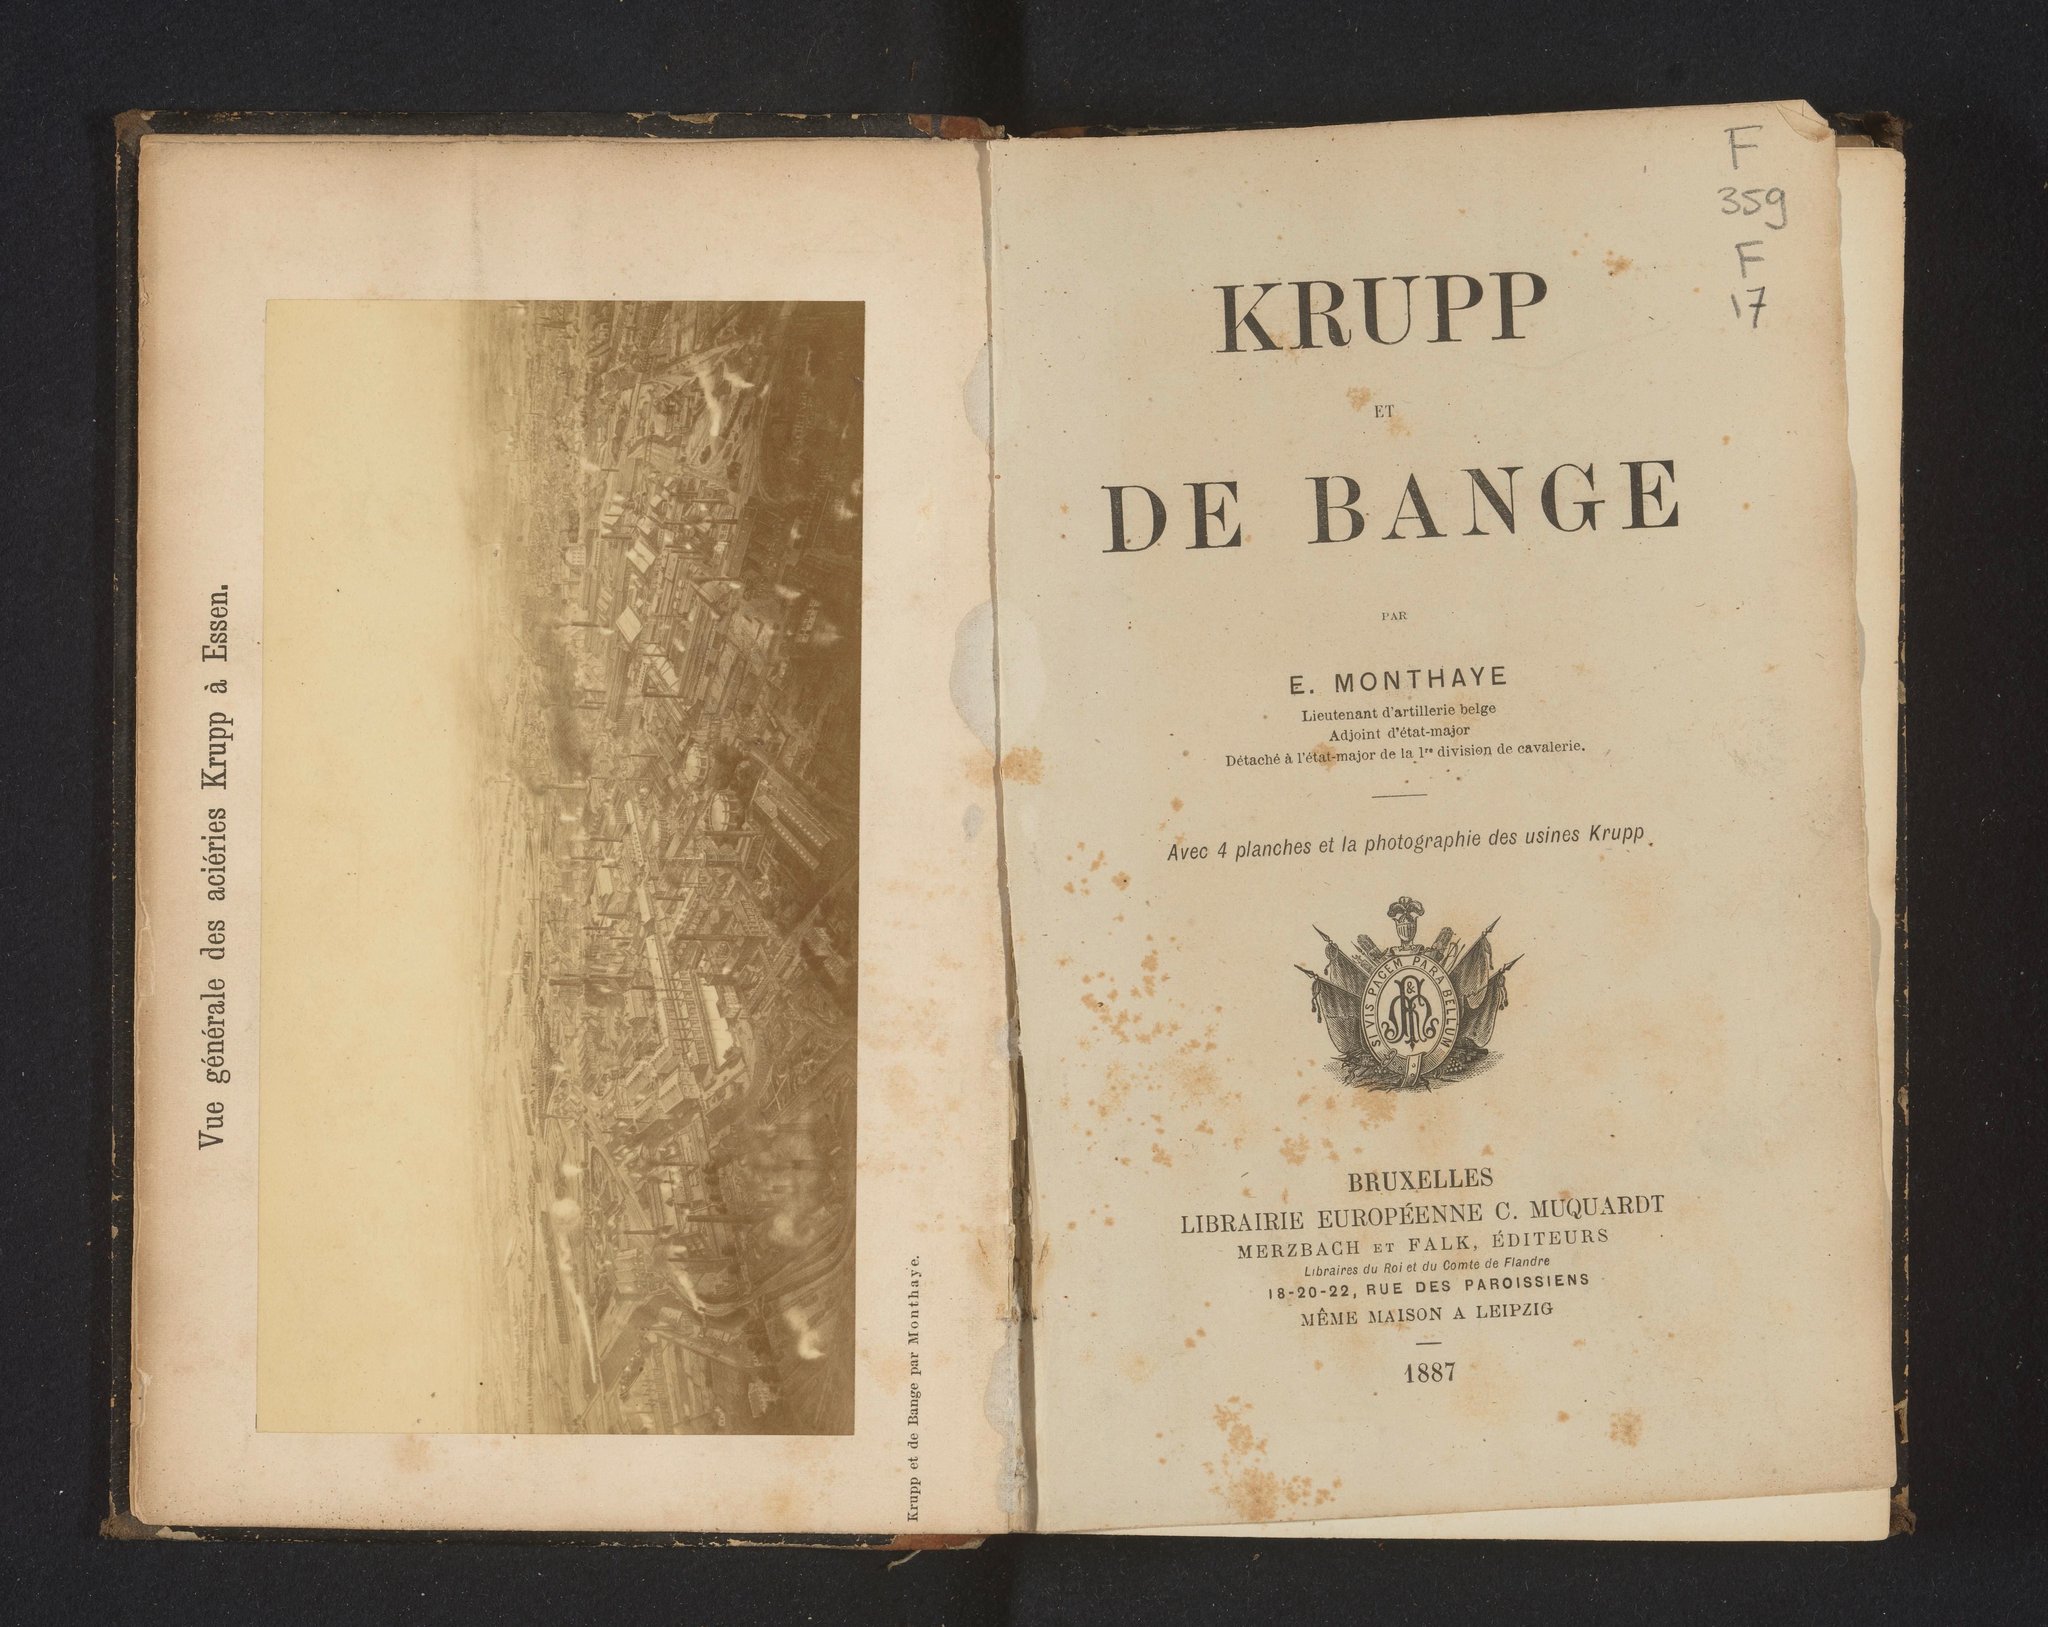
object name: reproduction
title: Fotoreproductie van een tekening van de staalfabriek van de familie Krupp in Essen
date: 1882-1887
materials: photographic support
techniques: albumen print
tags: factory-building, iron and steel industry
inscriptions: inscription: ‘Krupp et de Bange par Monthaye.’, name: ‘J. Sch[.]iner’